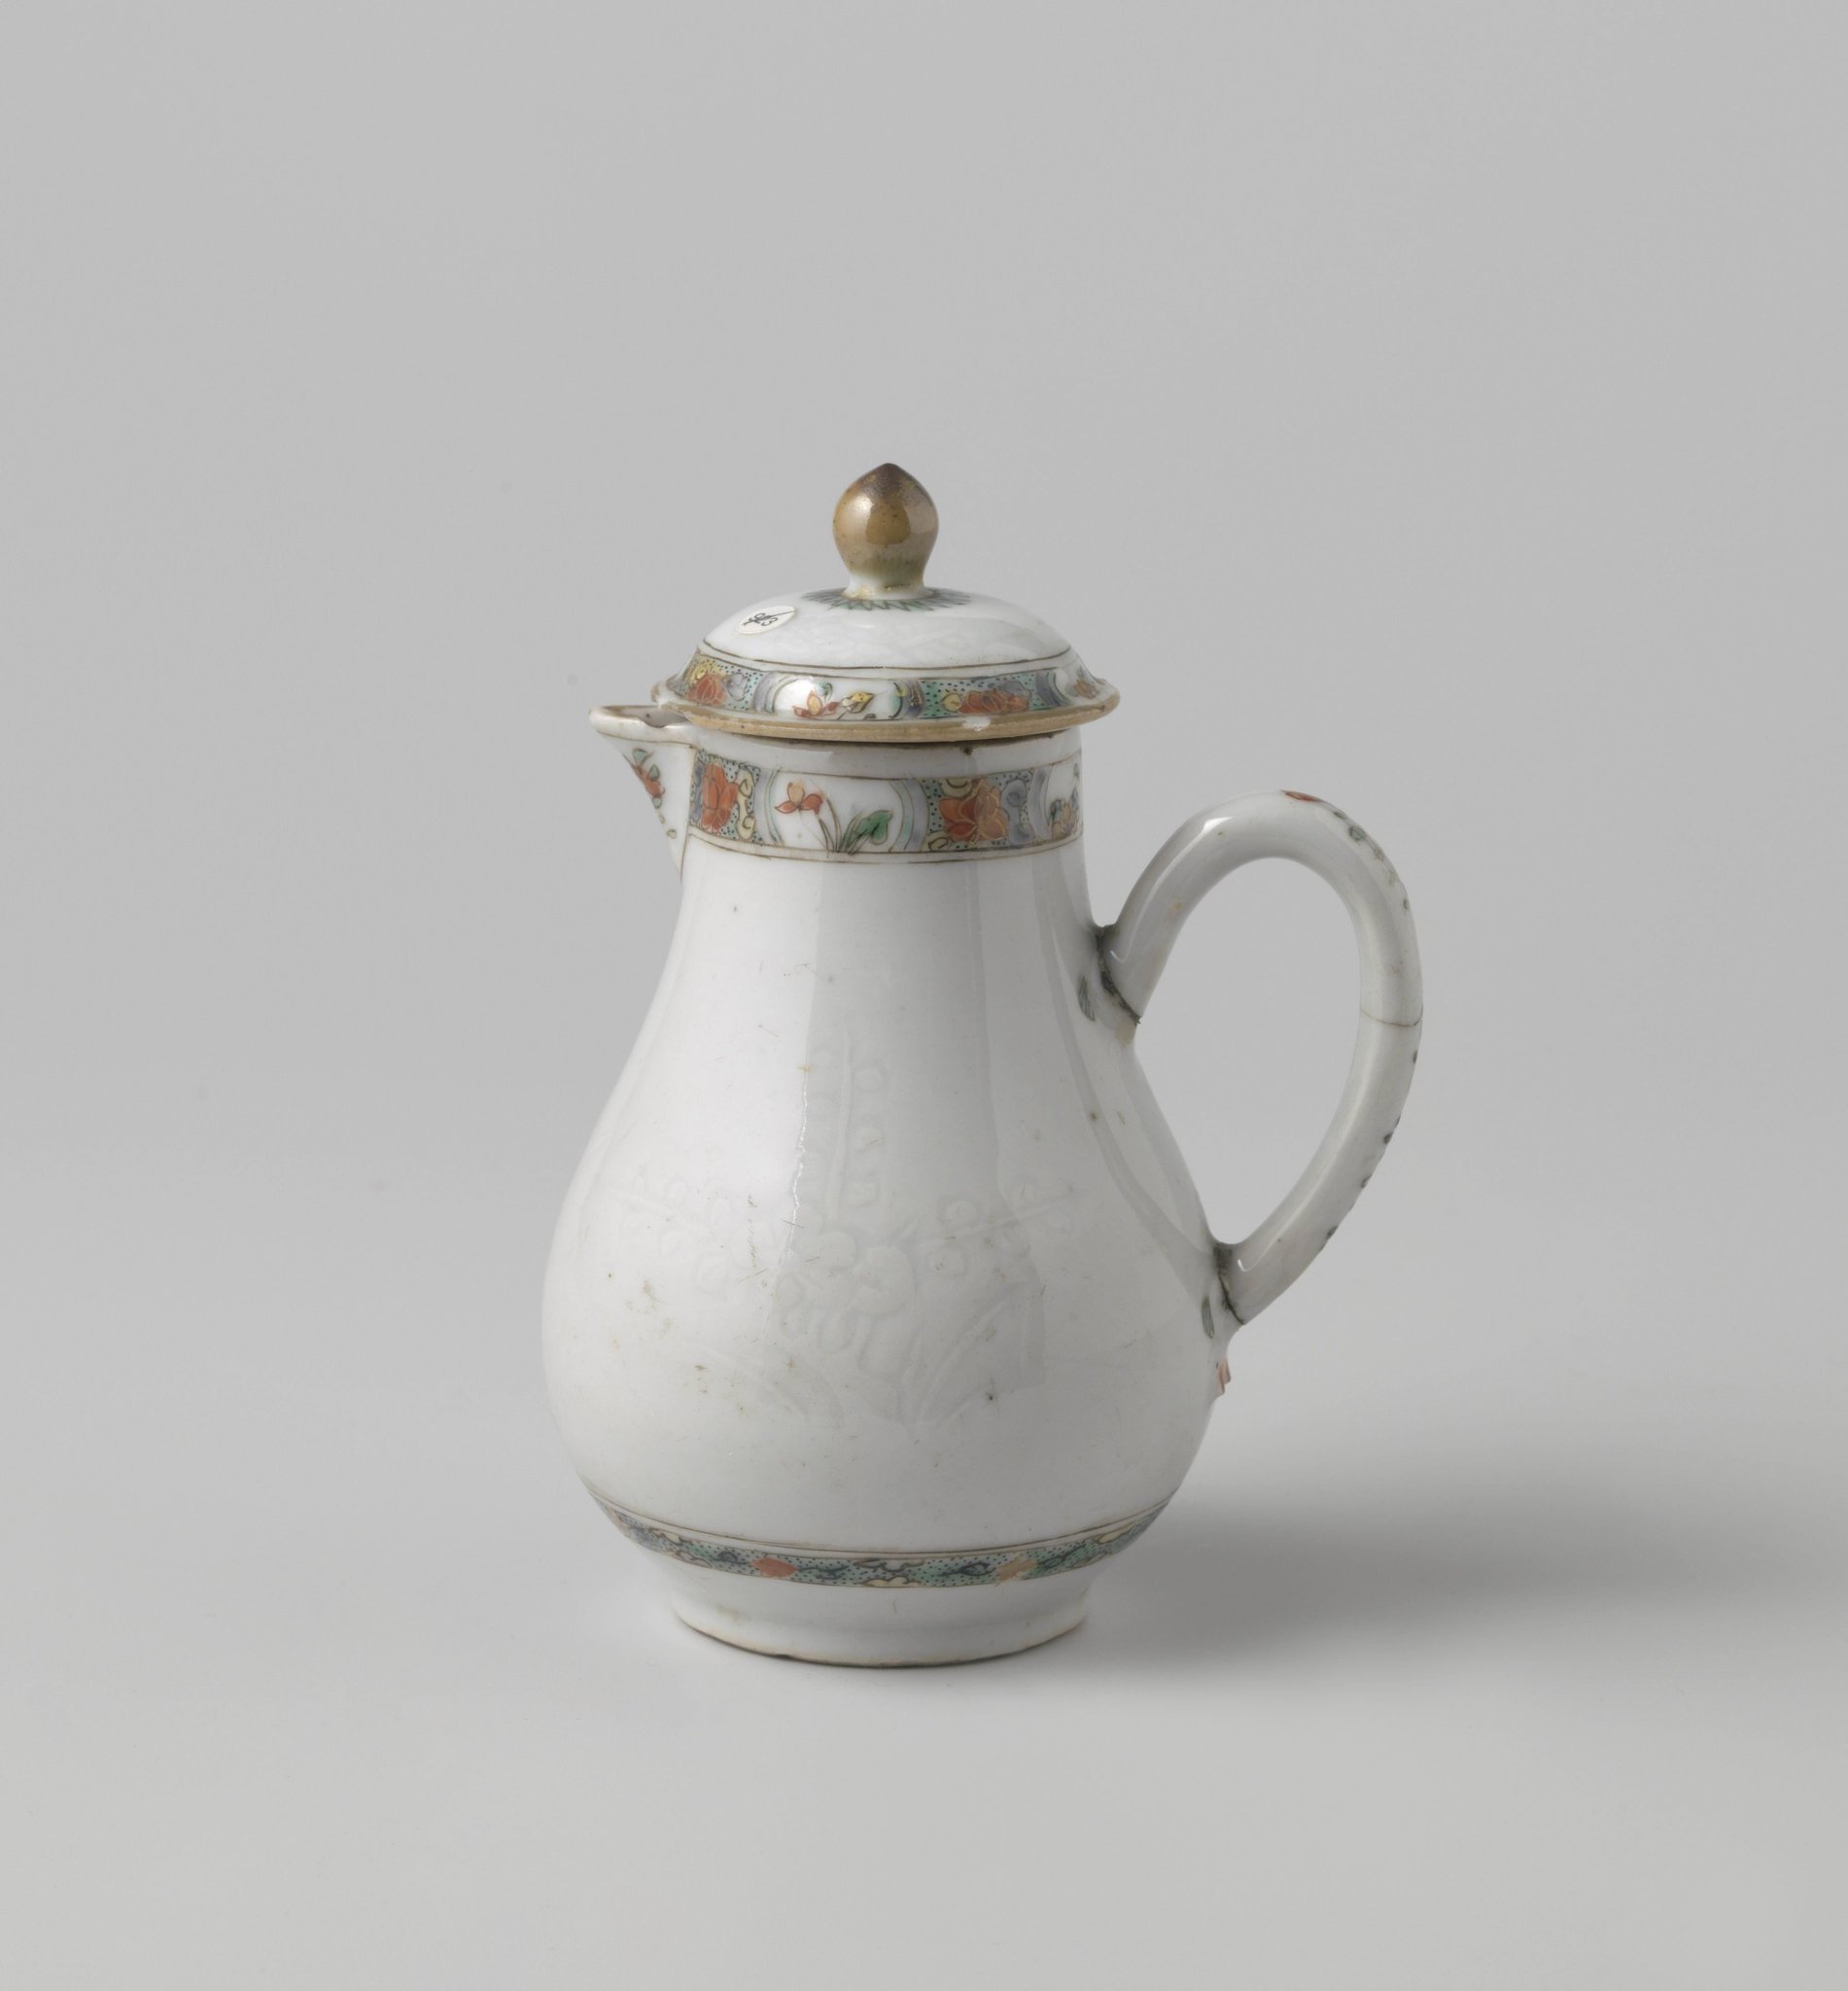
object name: milk jug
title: Cover of milk jug with onderglaze relief decoration with flowers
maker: Anonymous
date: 1700-1724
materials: glaze, gold, paint, porcelain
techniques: firing, relief, turning, vitrification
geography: china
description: Deksel met knop van melkkan van porselein, beschilderd op het glazuur in rood, groen, geel, aubergine, zwart en goud. De deksel met reliëfdecoratie, daaromheen een decoratieve band met bloemen afwisselend in cartouches en tegen een groene ondergrond met zwarte stippen. Zes chips in de deksel. Famille verte.